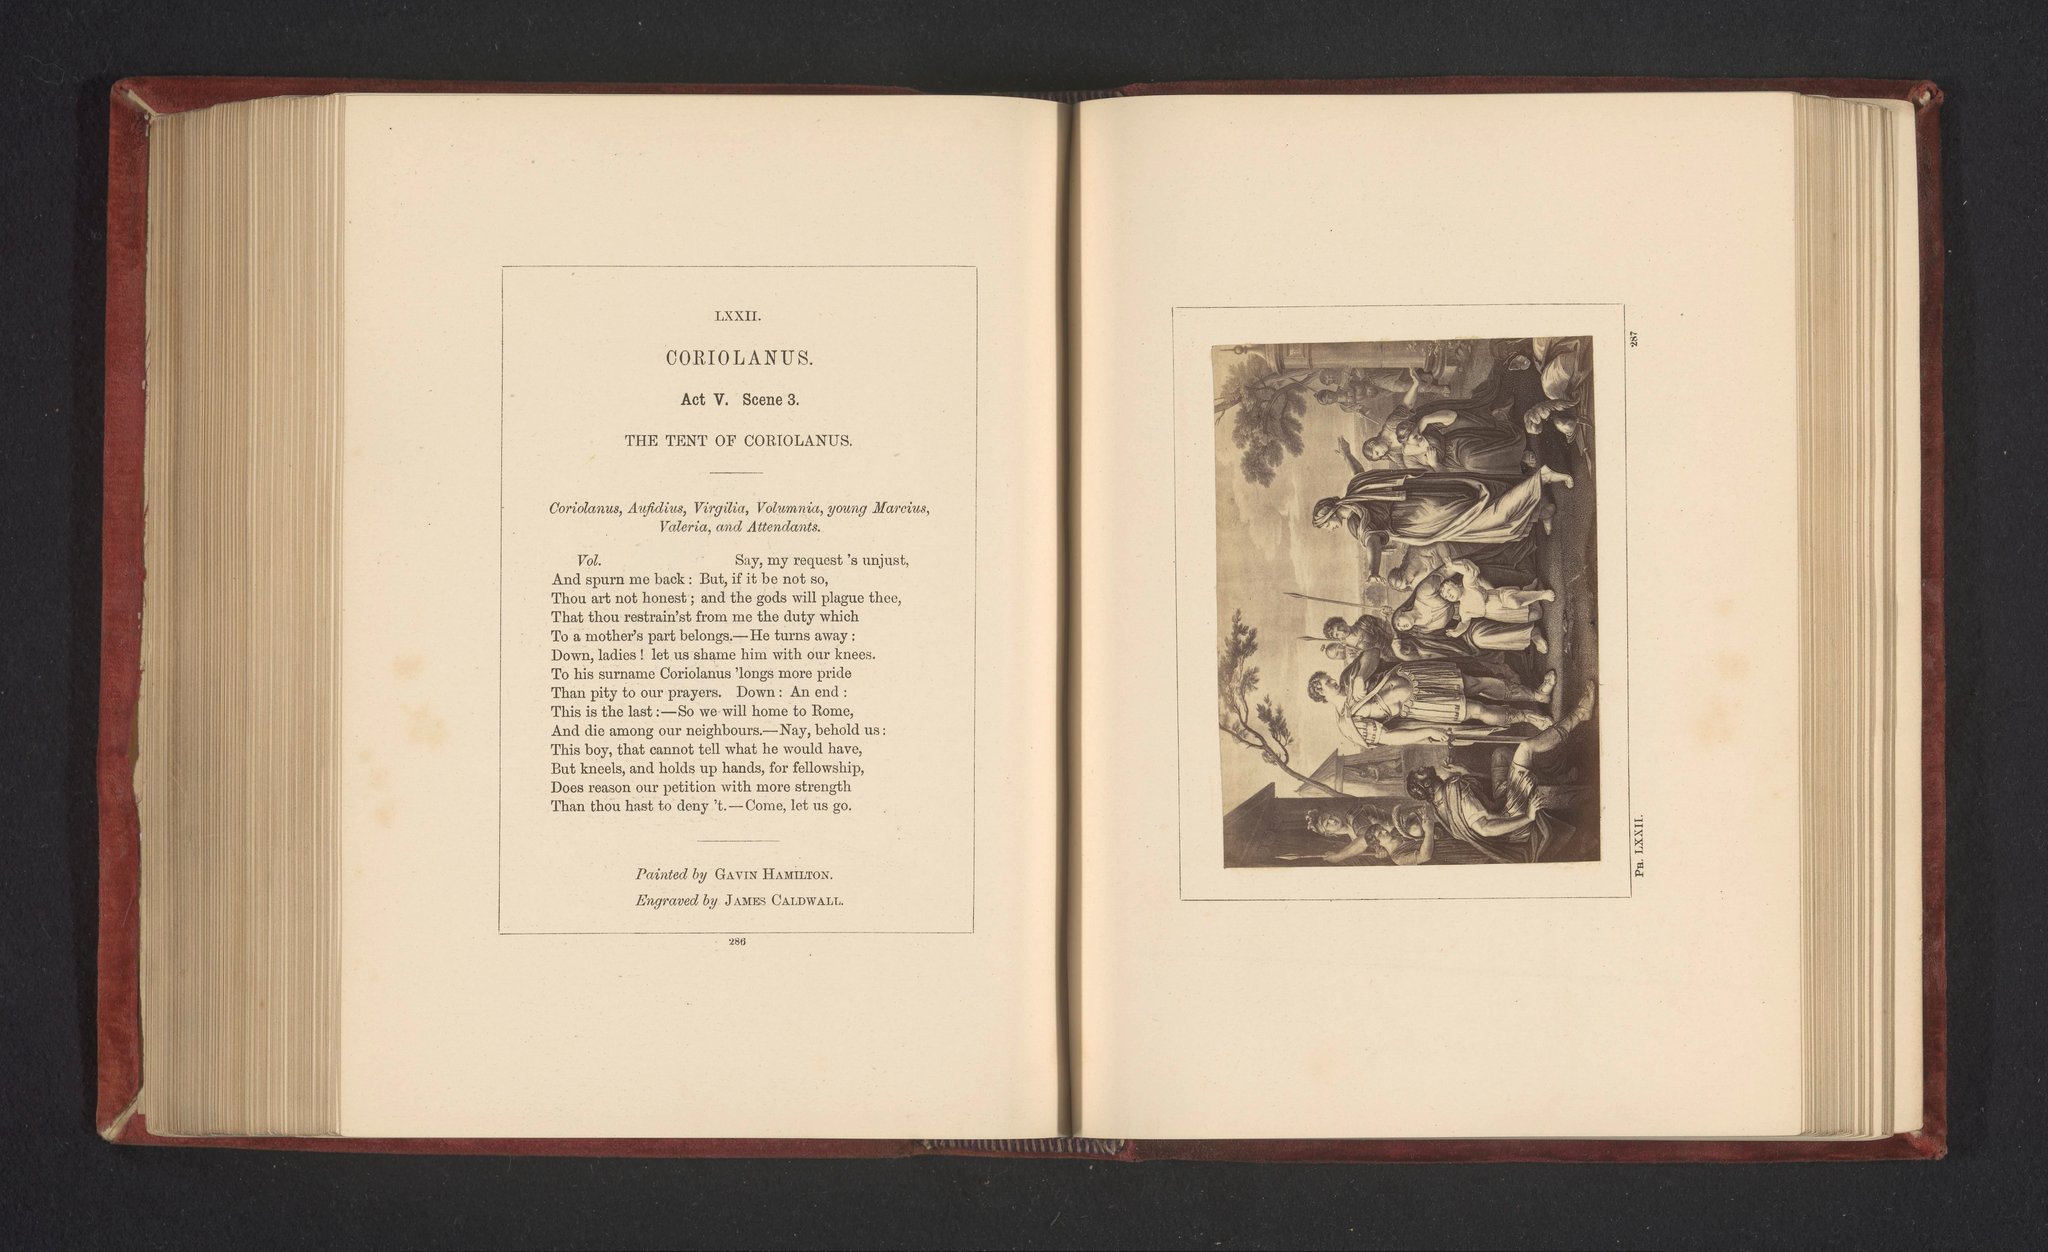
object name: photograph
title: Fotoreproductie van een prent naar een schilderij door Gavin Hamilton, voorstellend een scene uit Coriolanus door William Shakespeare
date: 1854-1864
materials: photographic support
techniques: albumen print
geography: london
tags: specific works of literature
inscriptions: number: ‘Ph. LXXII. 287’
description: Te zien is akte V, scene 3 met een gezelschap voor de tent van Gaius Marcius Coriolanus.